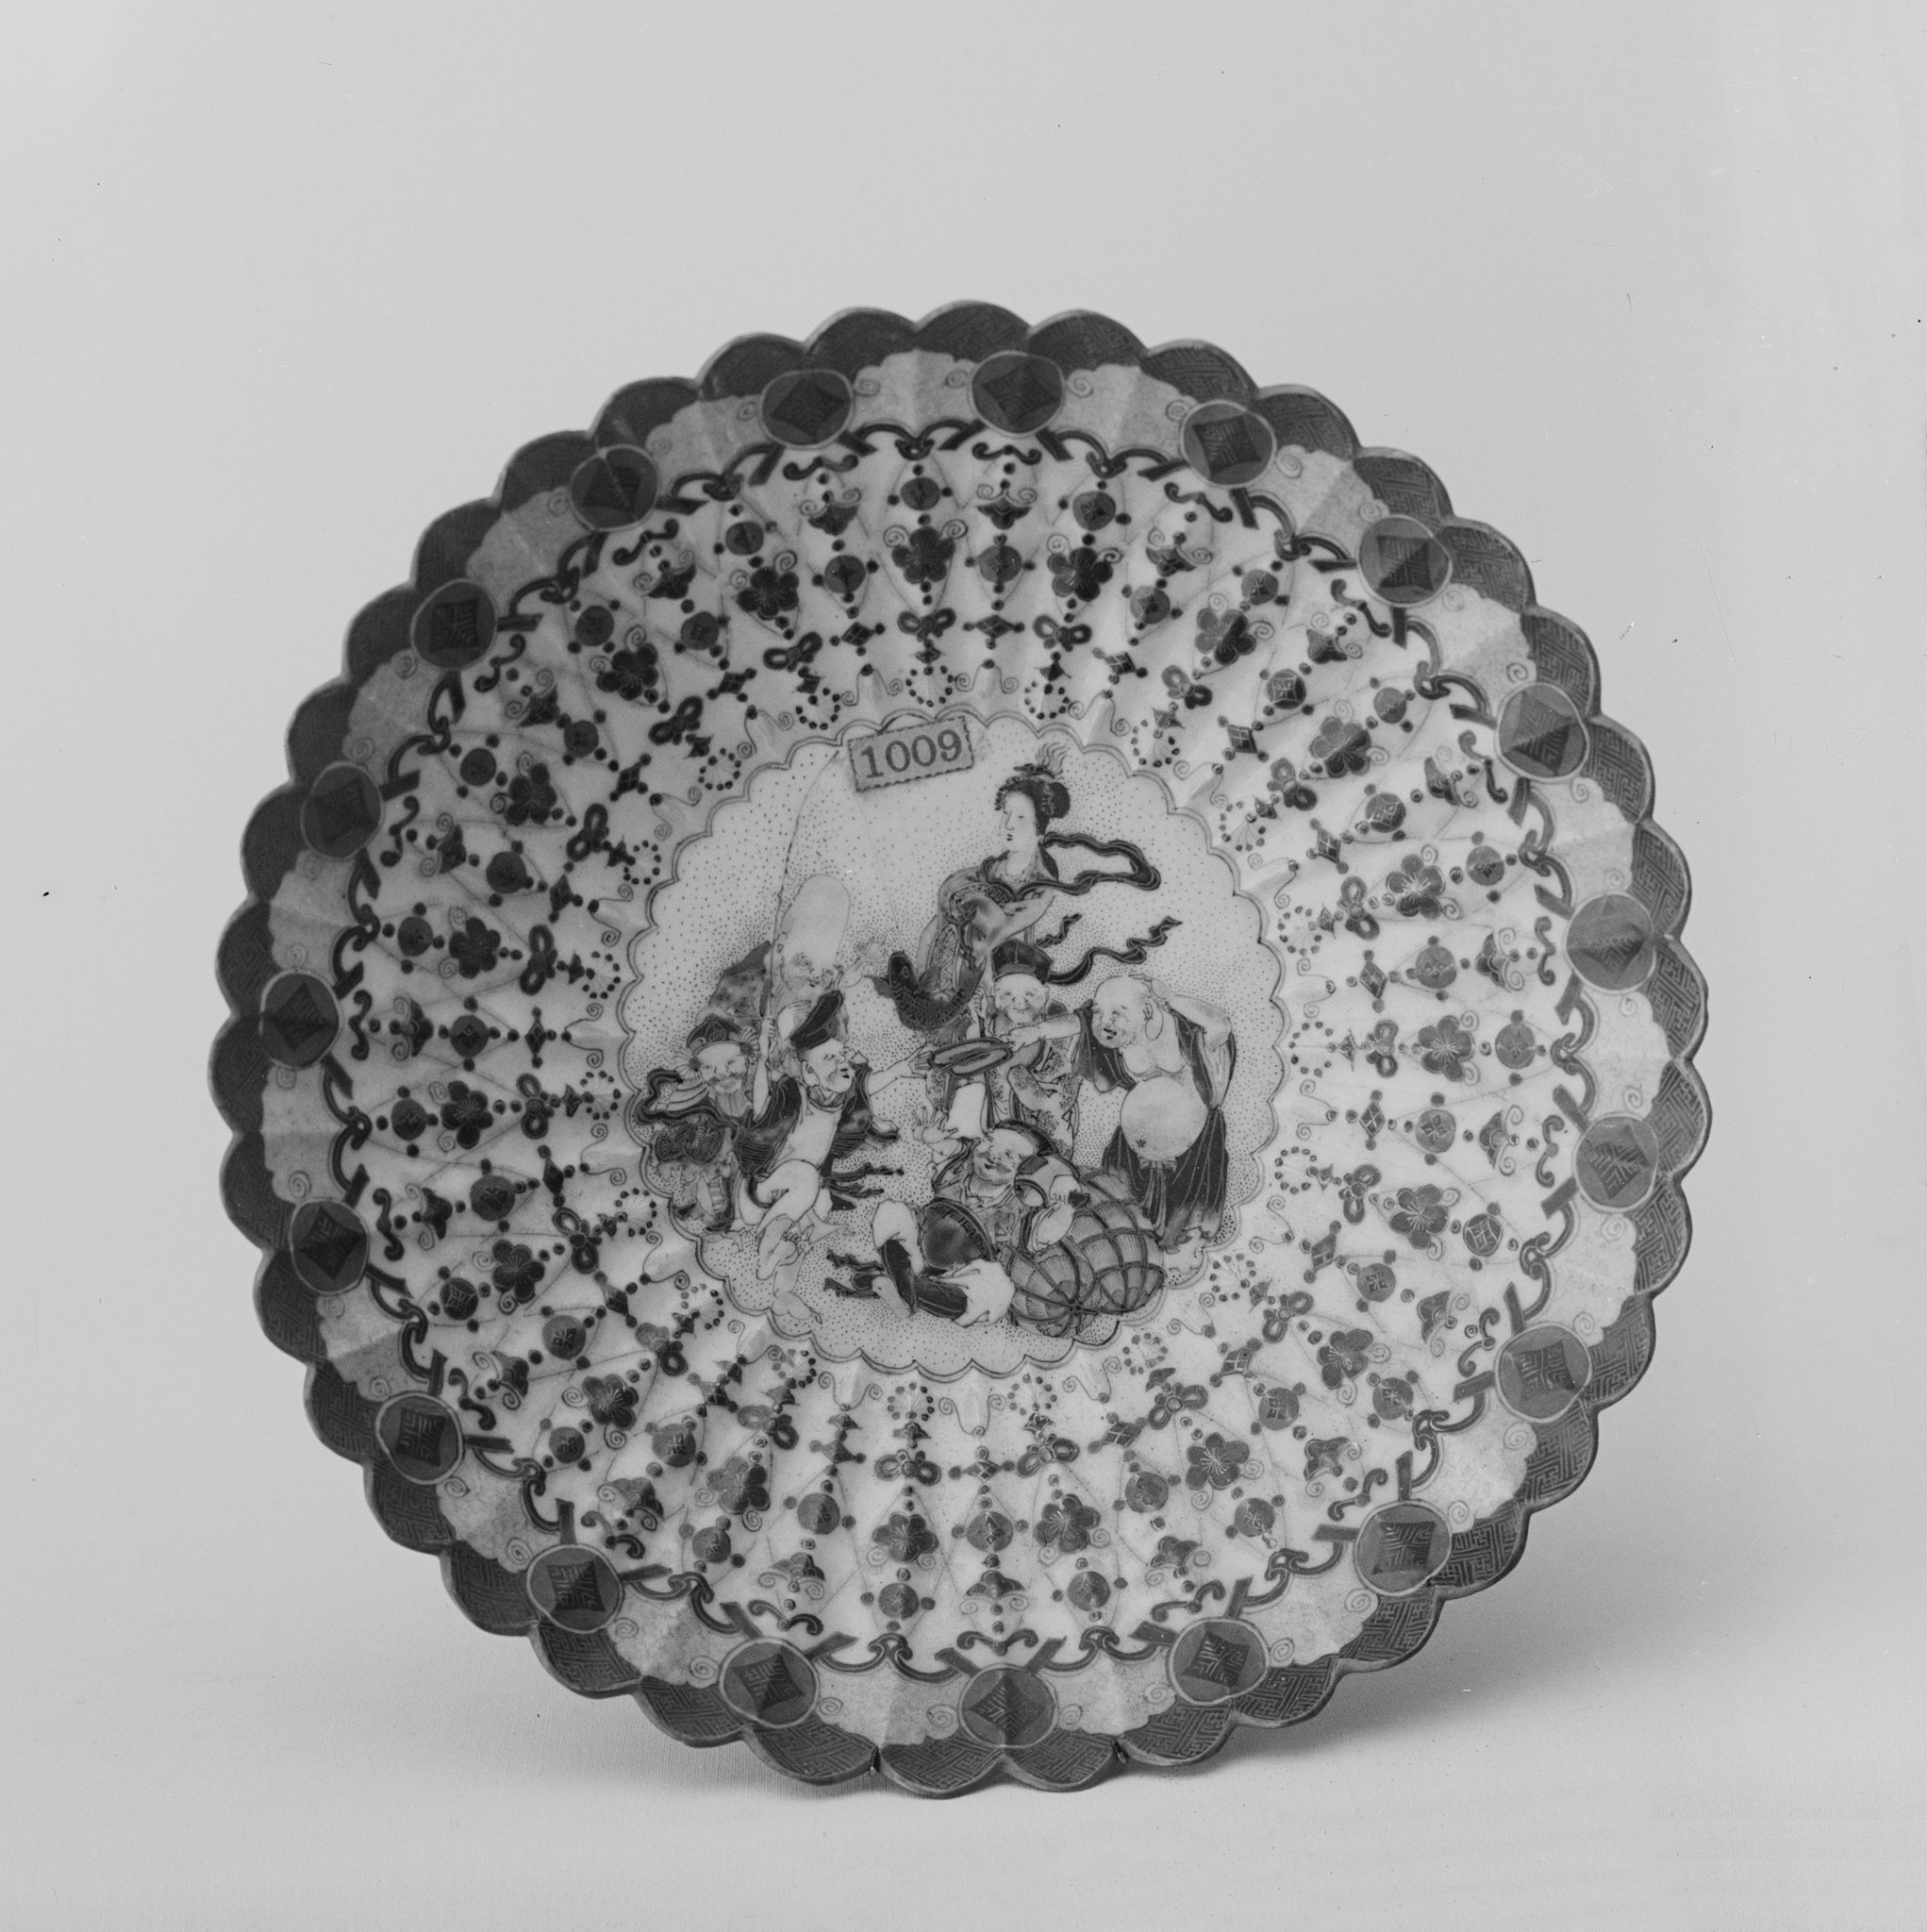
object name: dish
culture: japanese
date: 1801-1900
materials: enamel, porcelain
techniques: polychrome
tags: men,women